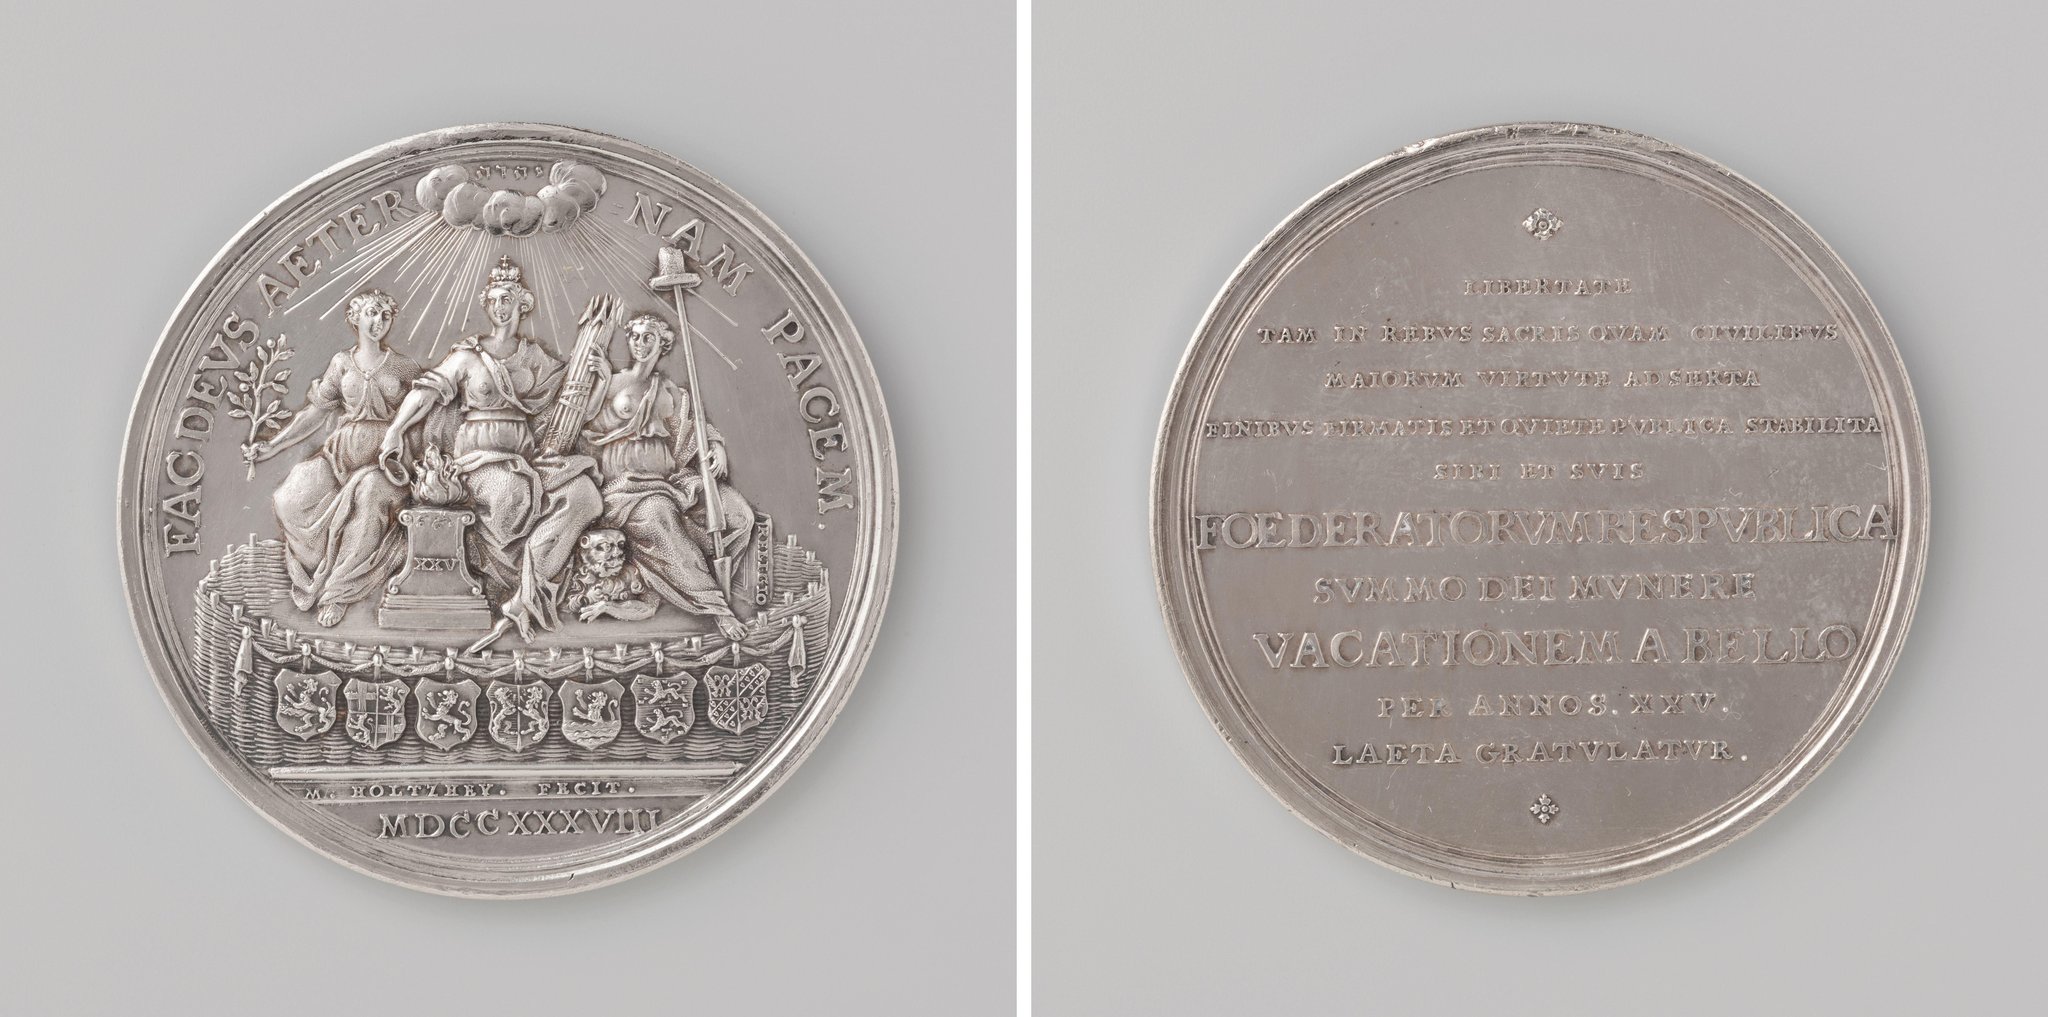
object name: history medal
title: Sedert vijfentwintig jaar vrede in de Nederlanden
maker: martinus holtzhey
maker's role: medailleur, muntmaker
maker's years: 1697-1764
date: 1738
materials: silver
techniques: striking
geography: amsterdam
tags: netherlands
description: Zilveren penning. Voorzijde: beschenen door hemellicht, waarin de naam van Jehova in het Hebreeuws staat, zitten de Verenigde Nederlanden, afgebeeld als gekroonde vrouw met roedebundel, in de Hollandse tuin, waaraan de wapens van de zeven gewesten zijn bevestigd en verricht een plengoffer op een branden altaar, waarop het opschrift XXV staat, naast haar de Vrede met olijftak en de Vrijheid met hoed op speer, bij hen liggen de Nederlandse leeuw en de bijbel binnen omschrift; afsnede. Keerzijde: opschrift.